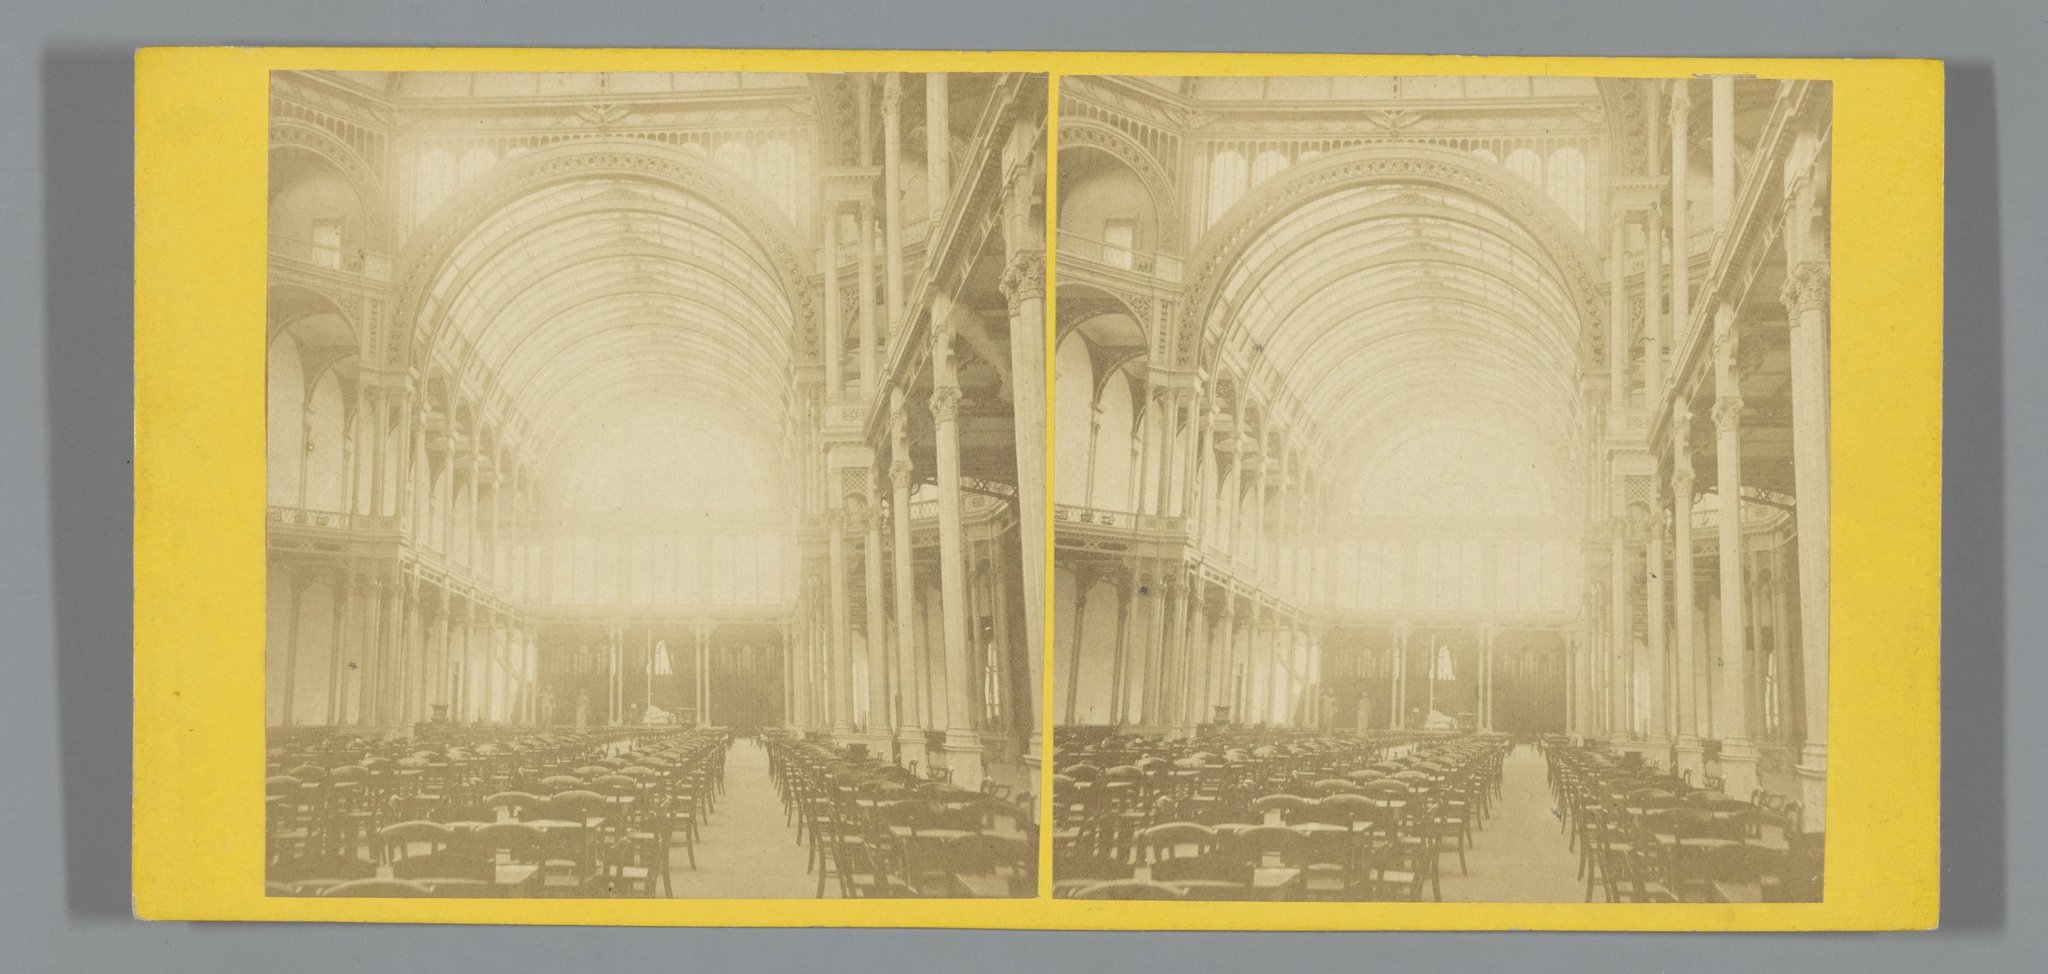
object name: stereograph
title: Gezicht op het interieur van het Paleis voor Volksvlijt in Amsterdam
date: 1860-1885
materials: cardboard, photographic support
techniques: albumen print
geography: amsterdam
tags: palace - aa - civic architecture: inside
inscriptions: inscription: ‘HET PALEIS VOOR VOLKSVLIJT/ te Amsterdam./ VAN BINNEN. No 1./ A. JAGER, WATER 110, TE AMSTERDAM.’, number: ‘No 10’, number: ‘1.50’, annotation: ‘[...] A'dam, +/- 1870 ([...])’